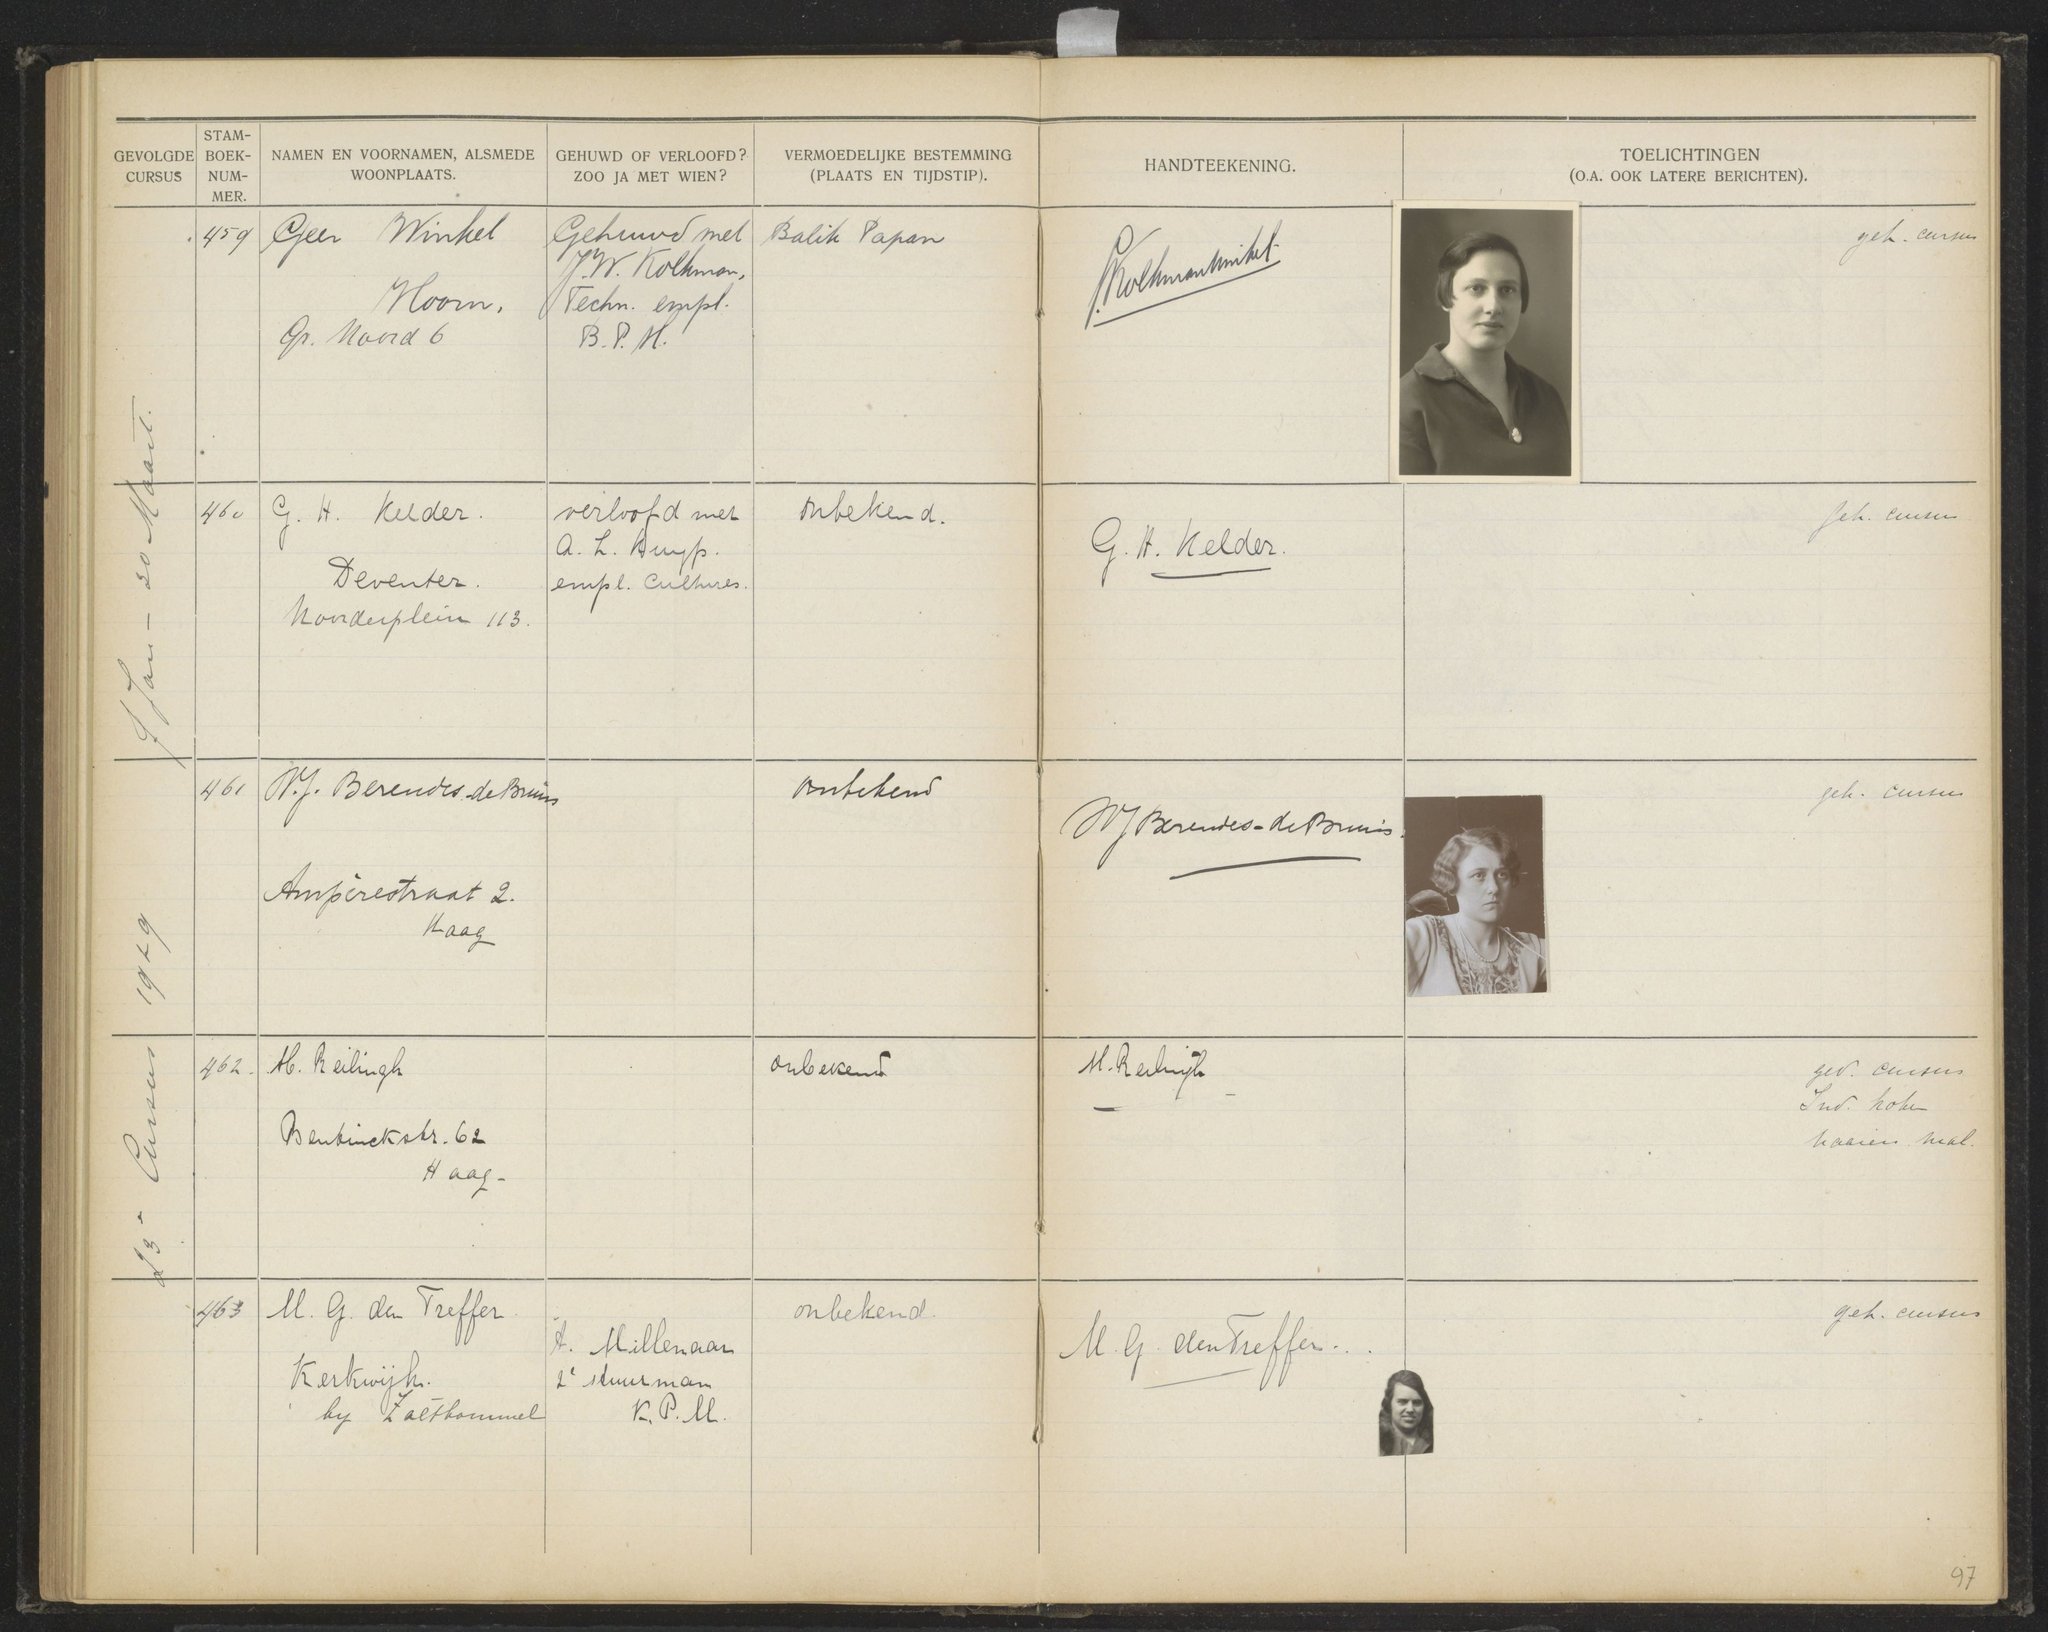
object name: photograph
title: Blad 97 uit Stamboek van de leerlingen der Koloniale School voor Meisjes en Vrouwen te 's-Gravenhage deel I (1921-1929)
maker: Anonymous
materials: paper, photographic support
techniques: photography, printing, writing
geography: the hague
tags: further education (+ pupil), further education, the hague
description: Twee pagina's met gegevens van de deelnemers aan de 23e driemaandelijkse cursus van 7 januari tot en met 30 maart 1929, stamboeknummers 459 tot en met 463. Onderdeel van Stamboek van de leerlingen der Koloniale School voor Meisjes en Vrouwen te 's-Gravenhage deel I (1921-1929).